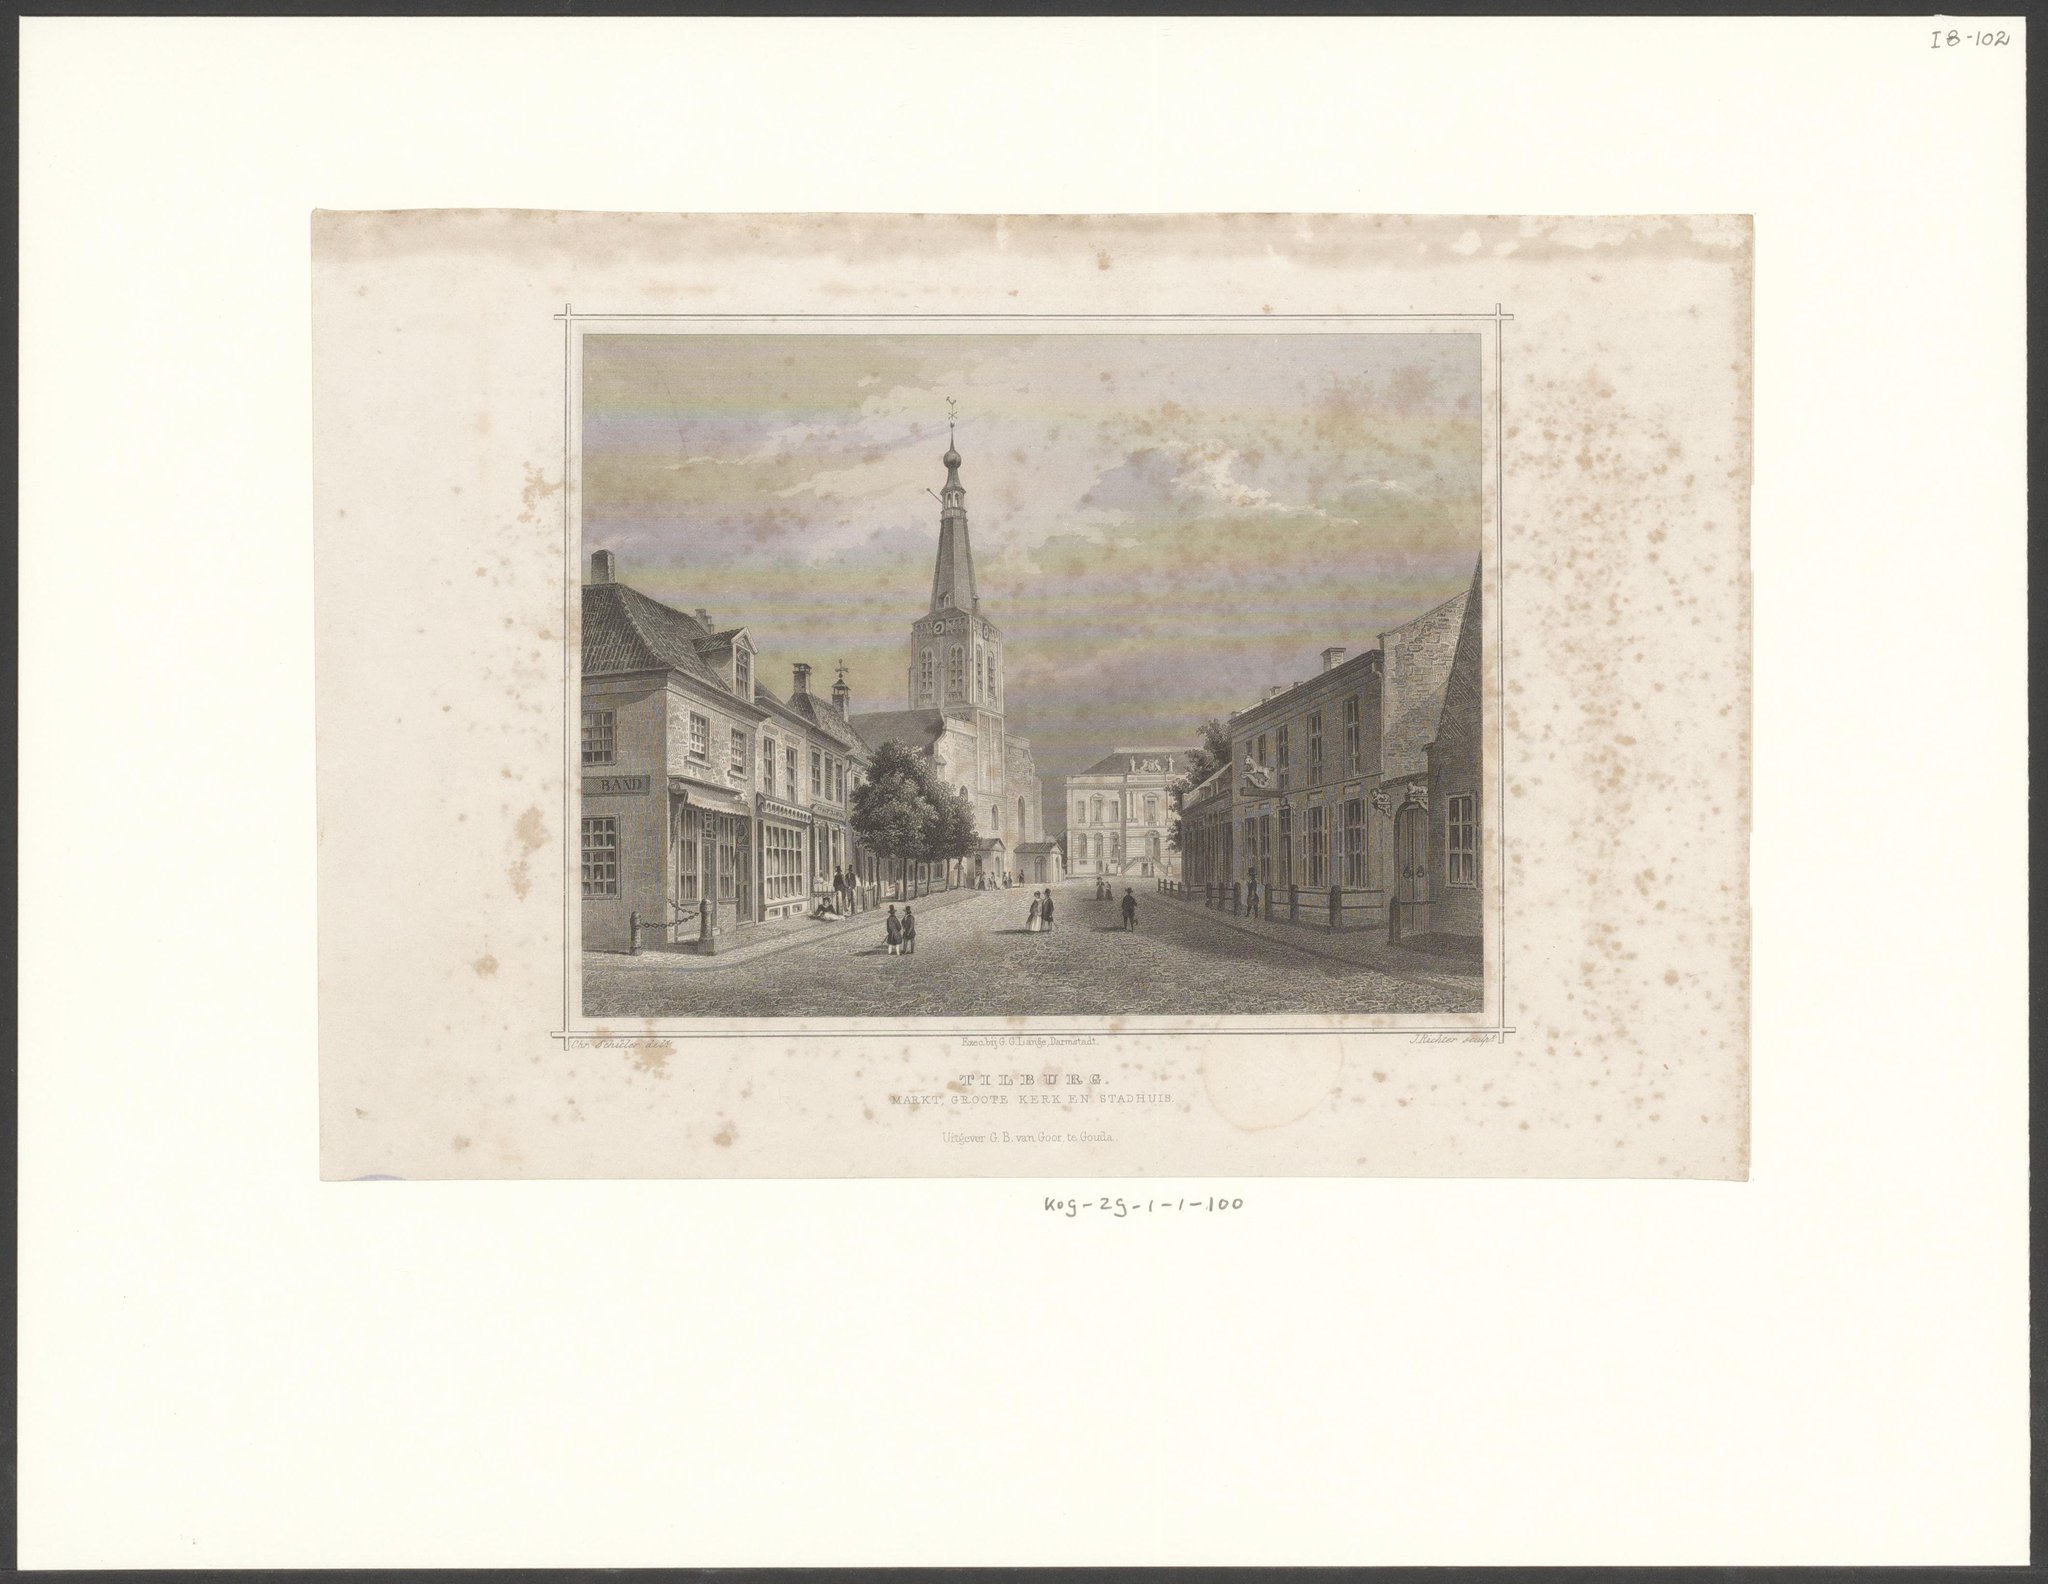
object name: book illustration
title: Tilburg. Markt, Groote Kerk en Stadhuis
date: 1855-1857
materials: paper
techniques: engraving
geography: gouda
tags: church (exterior), townhall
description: Prent uit: Terwen, J.L. Het koningrijk der Nederlanden (...). 2 dln. Gouda: G.B. van Goor, 1857. Dezelfde prent, met een ander onderschrift, komt ook voor in: Der Rhein und die Rheinlande in malerischen Original-ansichten. 3 dln. Darmstadt: G.G. Lange, 1863.